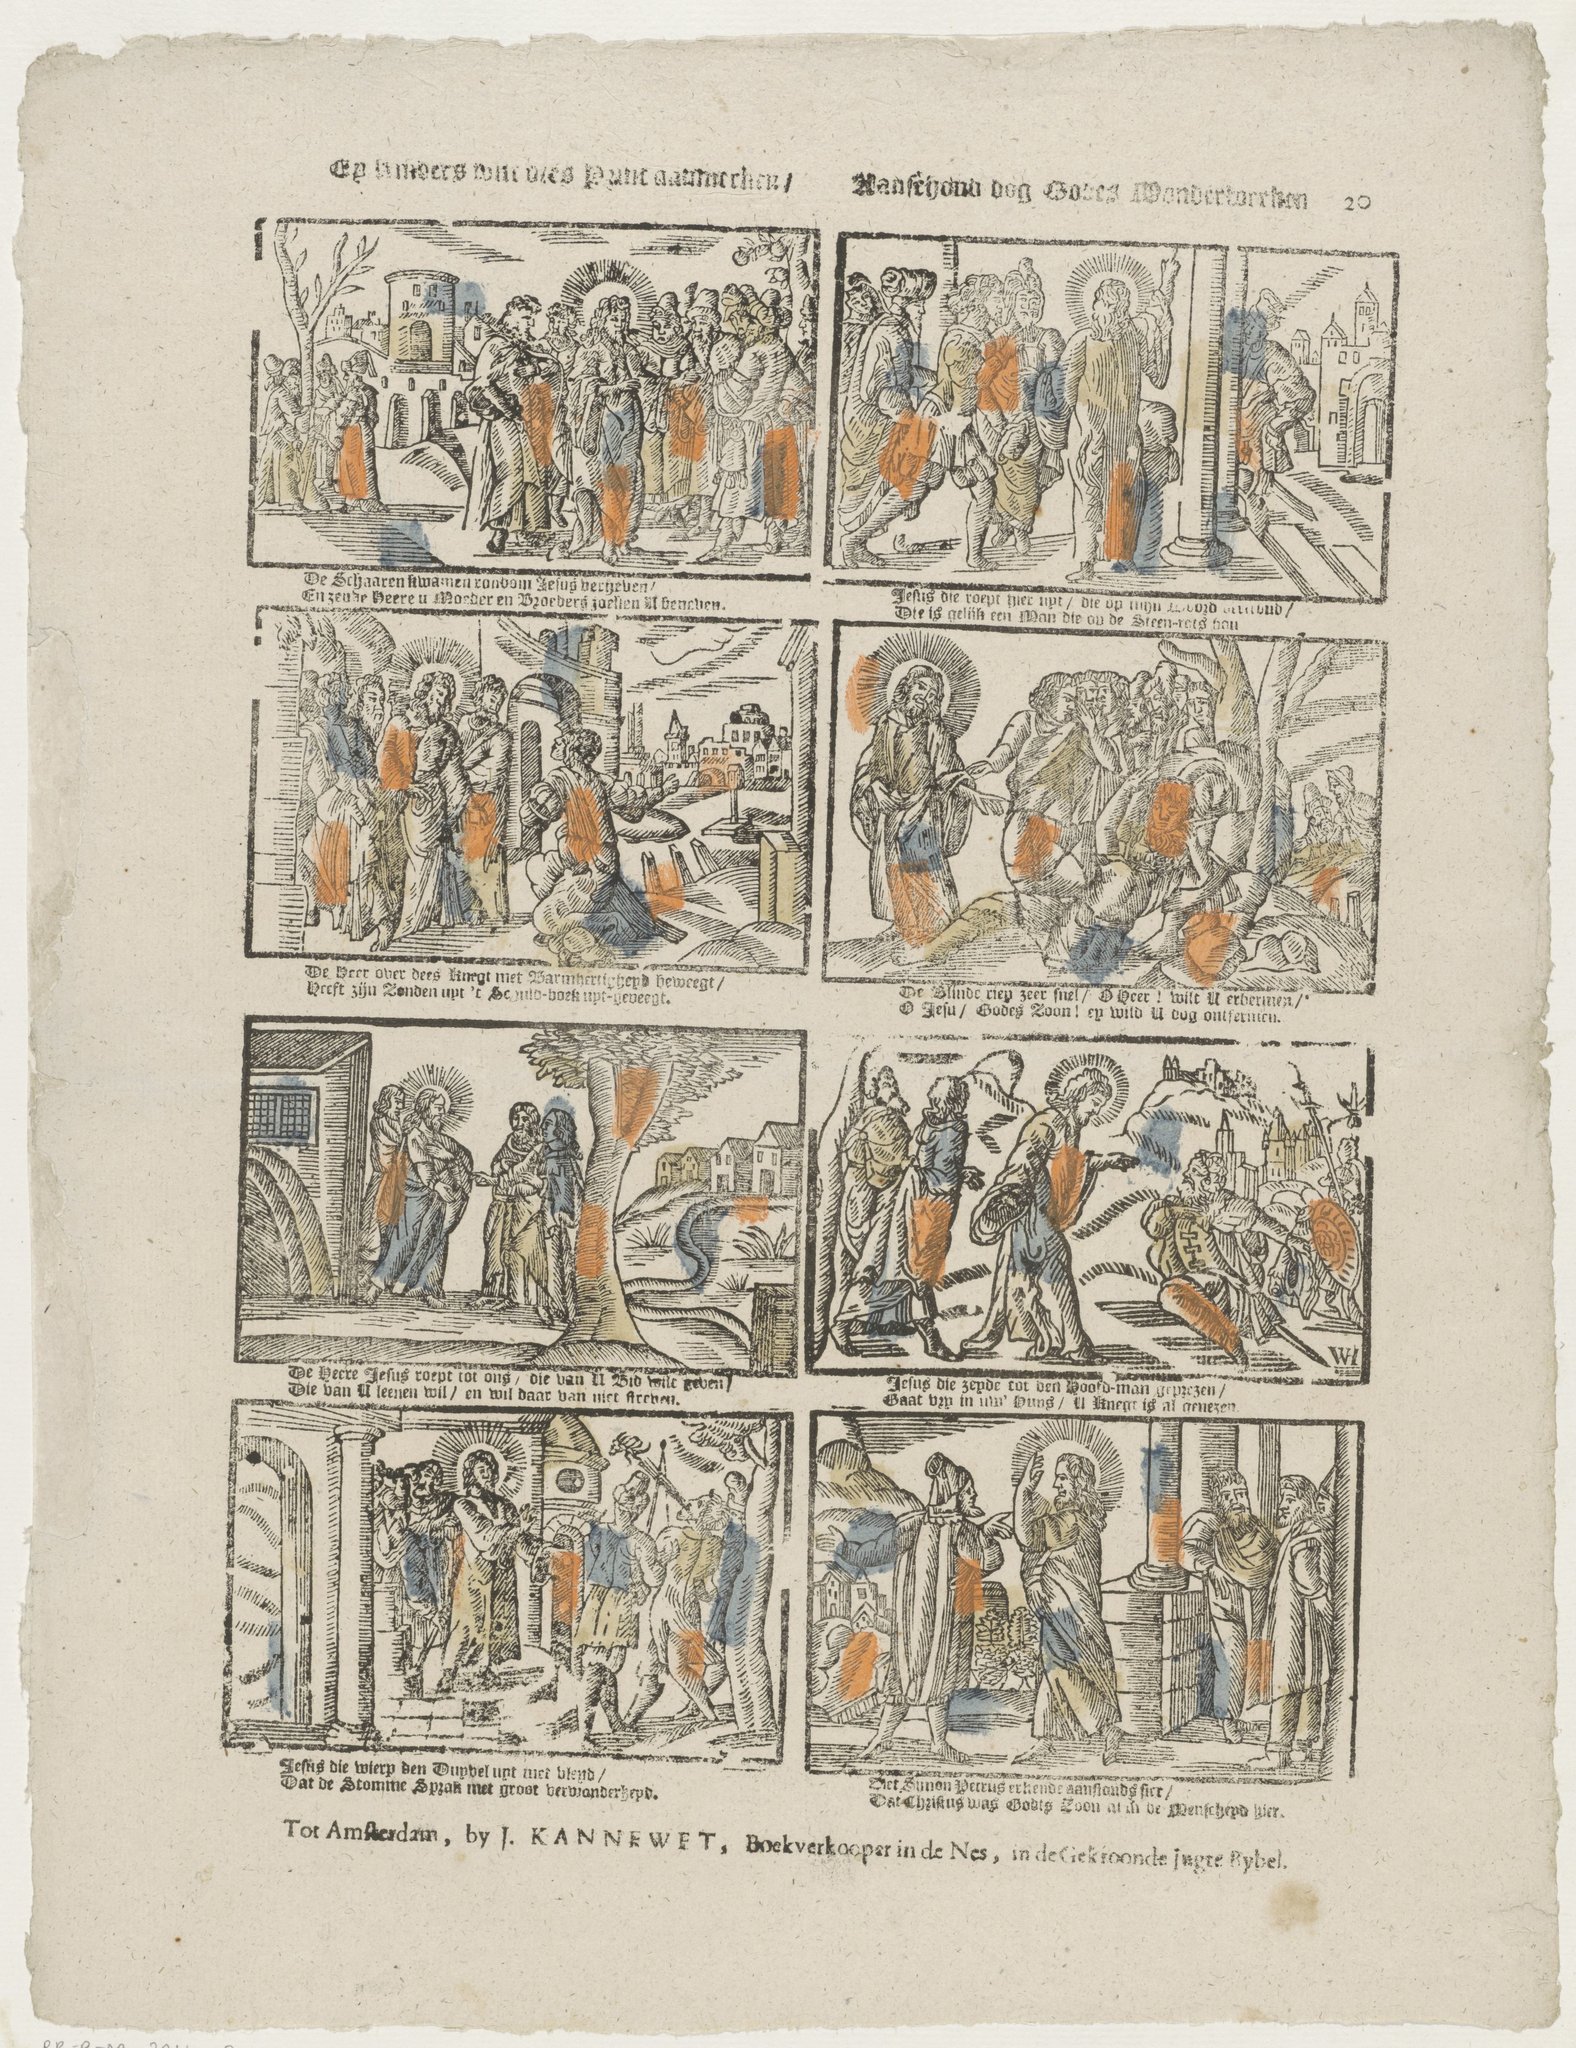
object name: print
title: Ey kinders wilt dees print aanmerken / Aanschoud dog Godes wonderwerken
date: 1725-1780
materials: paper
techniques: colour, letterpress printing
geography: netherlands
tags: public life of christ: from his baptism until the passion, new testament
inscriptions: collector's mark: Lugt 2760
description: Blad met 8 voorstellingen van verhalen uit het Nieuwe Testament over de wonderen van Christus. Onder elke afbeelding een vers. Genummerd rechtsboven: 20.